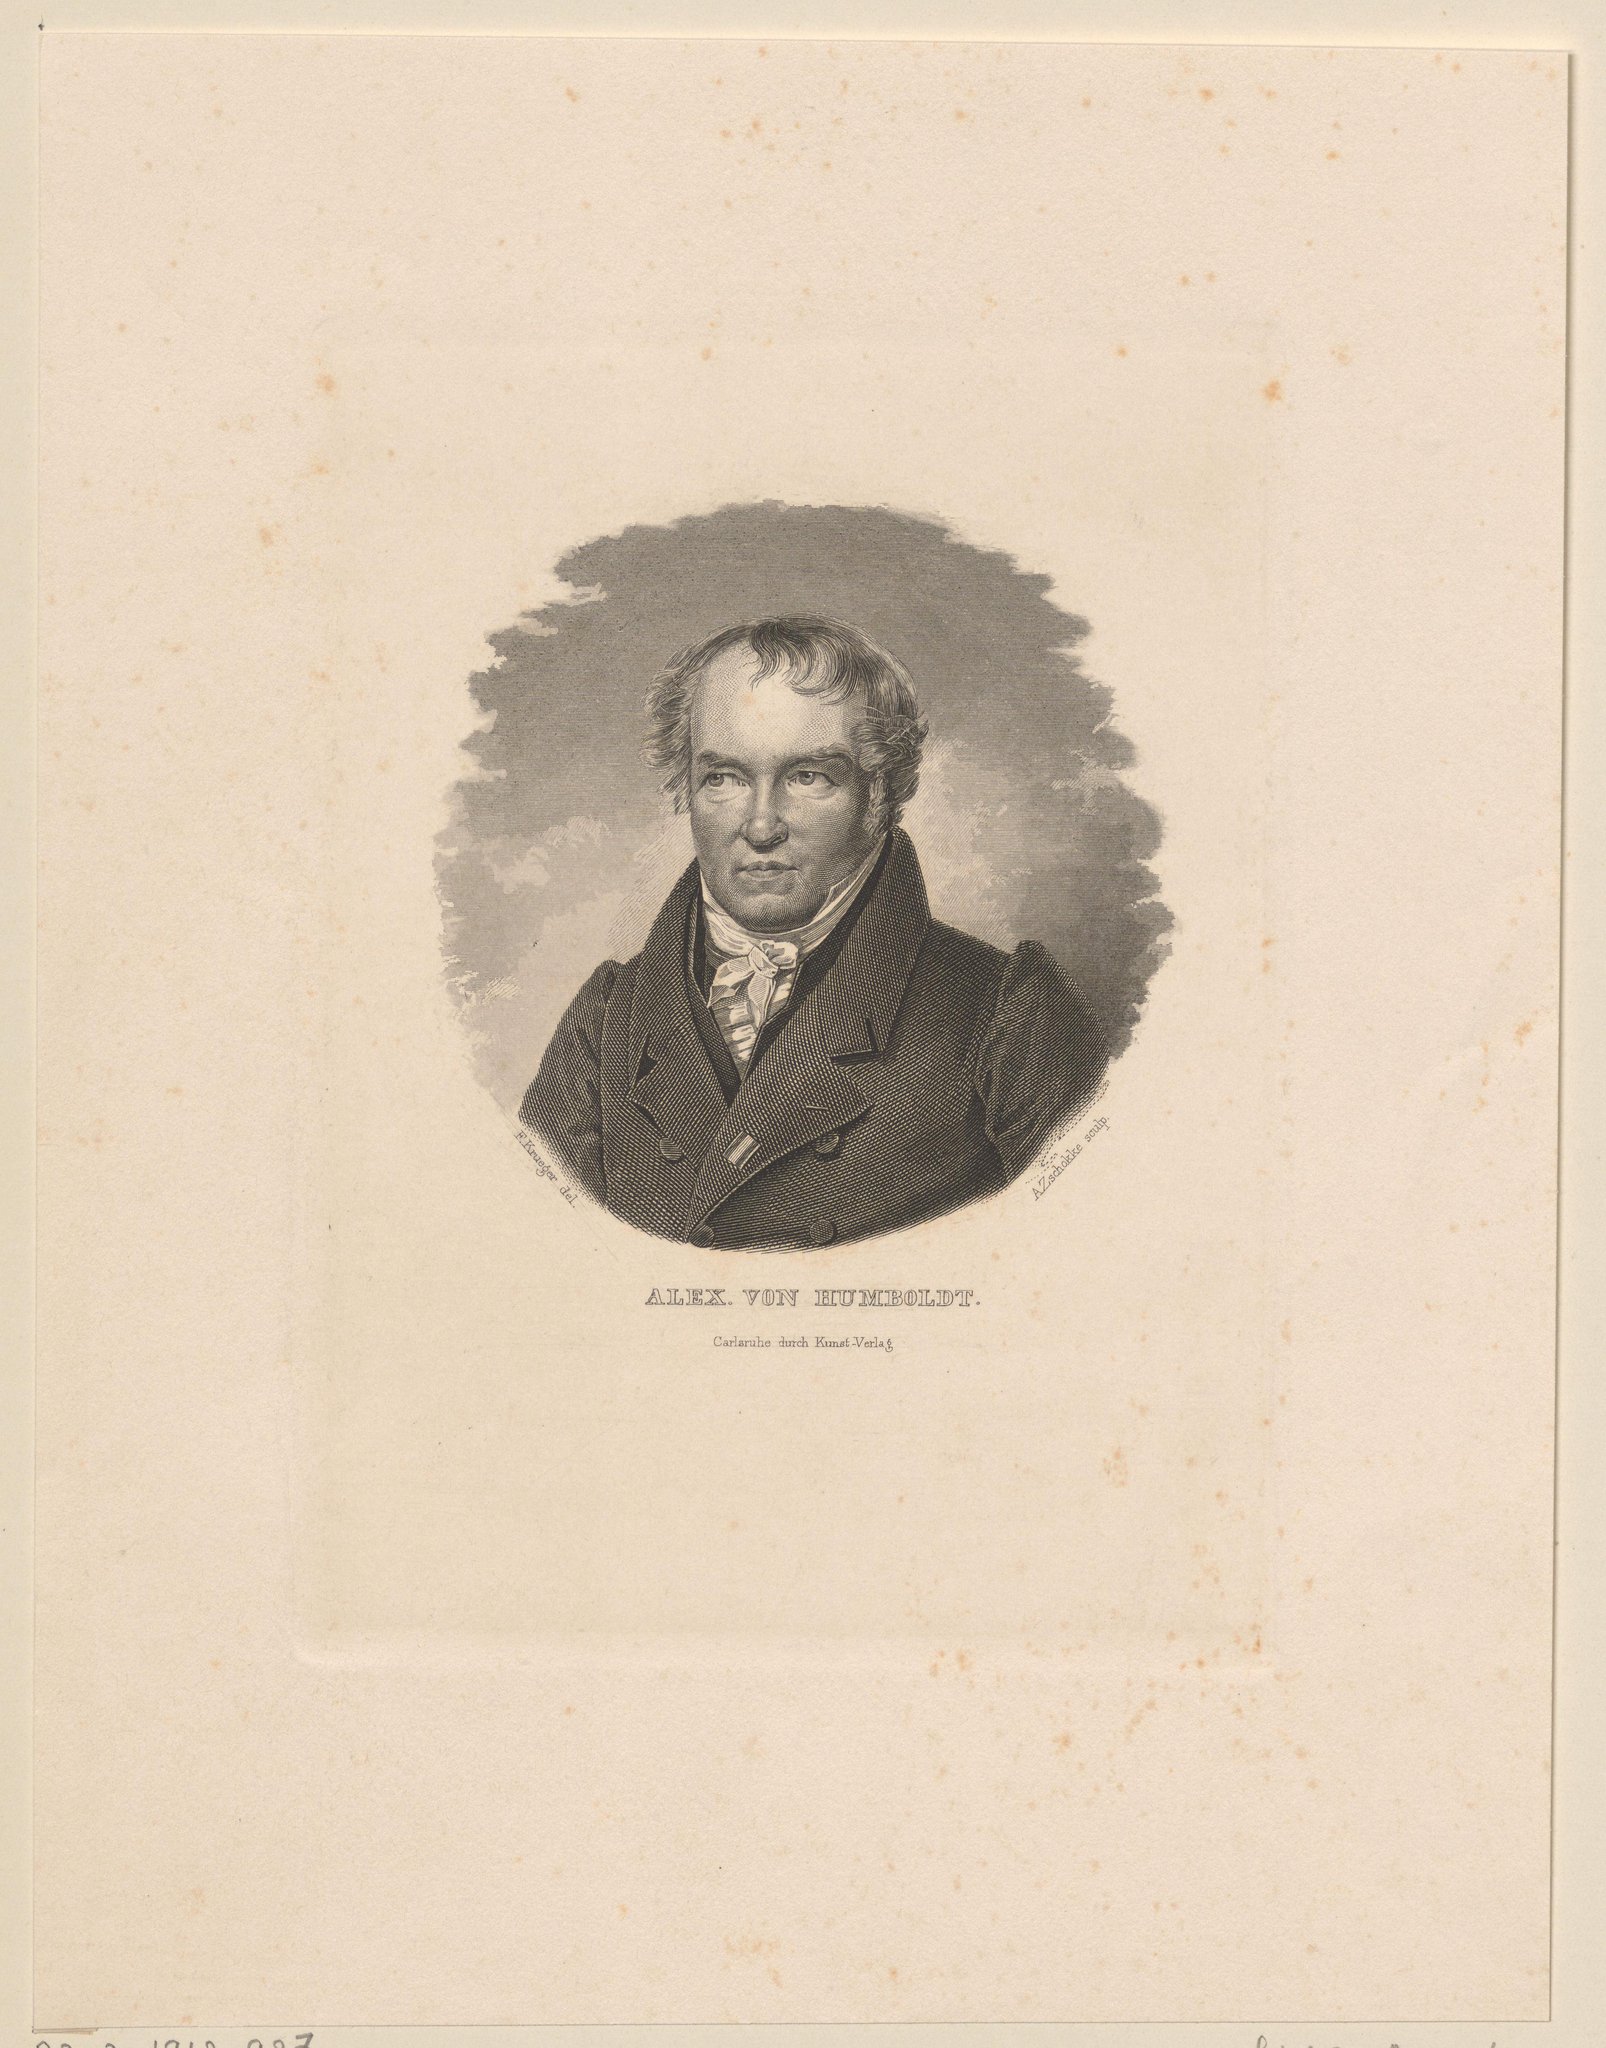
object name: print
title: Portret van Alexander von Humboldt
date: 1850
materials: paper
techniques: engraving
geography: karlsruhe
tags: berlin, traveler, historical persons, biology (+ portrait of scholar, scientist)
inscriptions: collector's mark: Lugt 2233